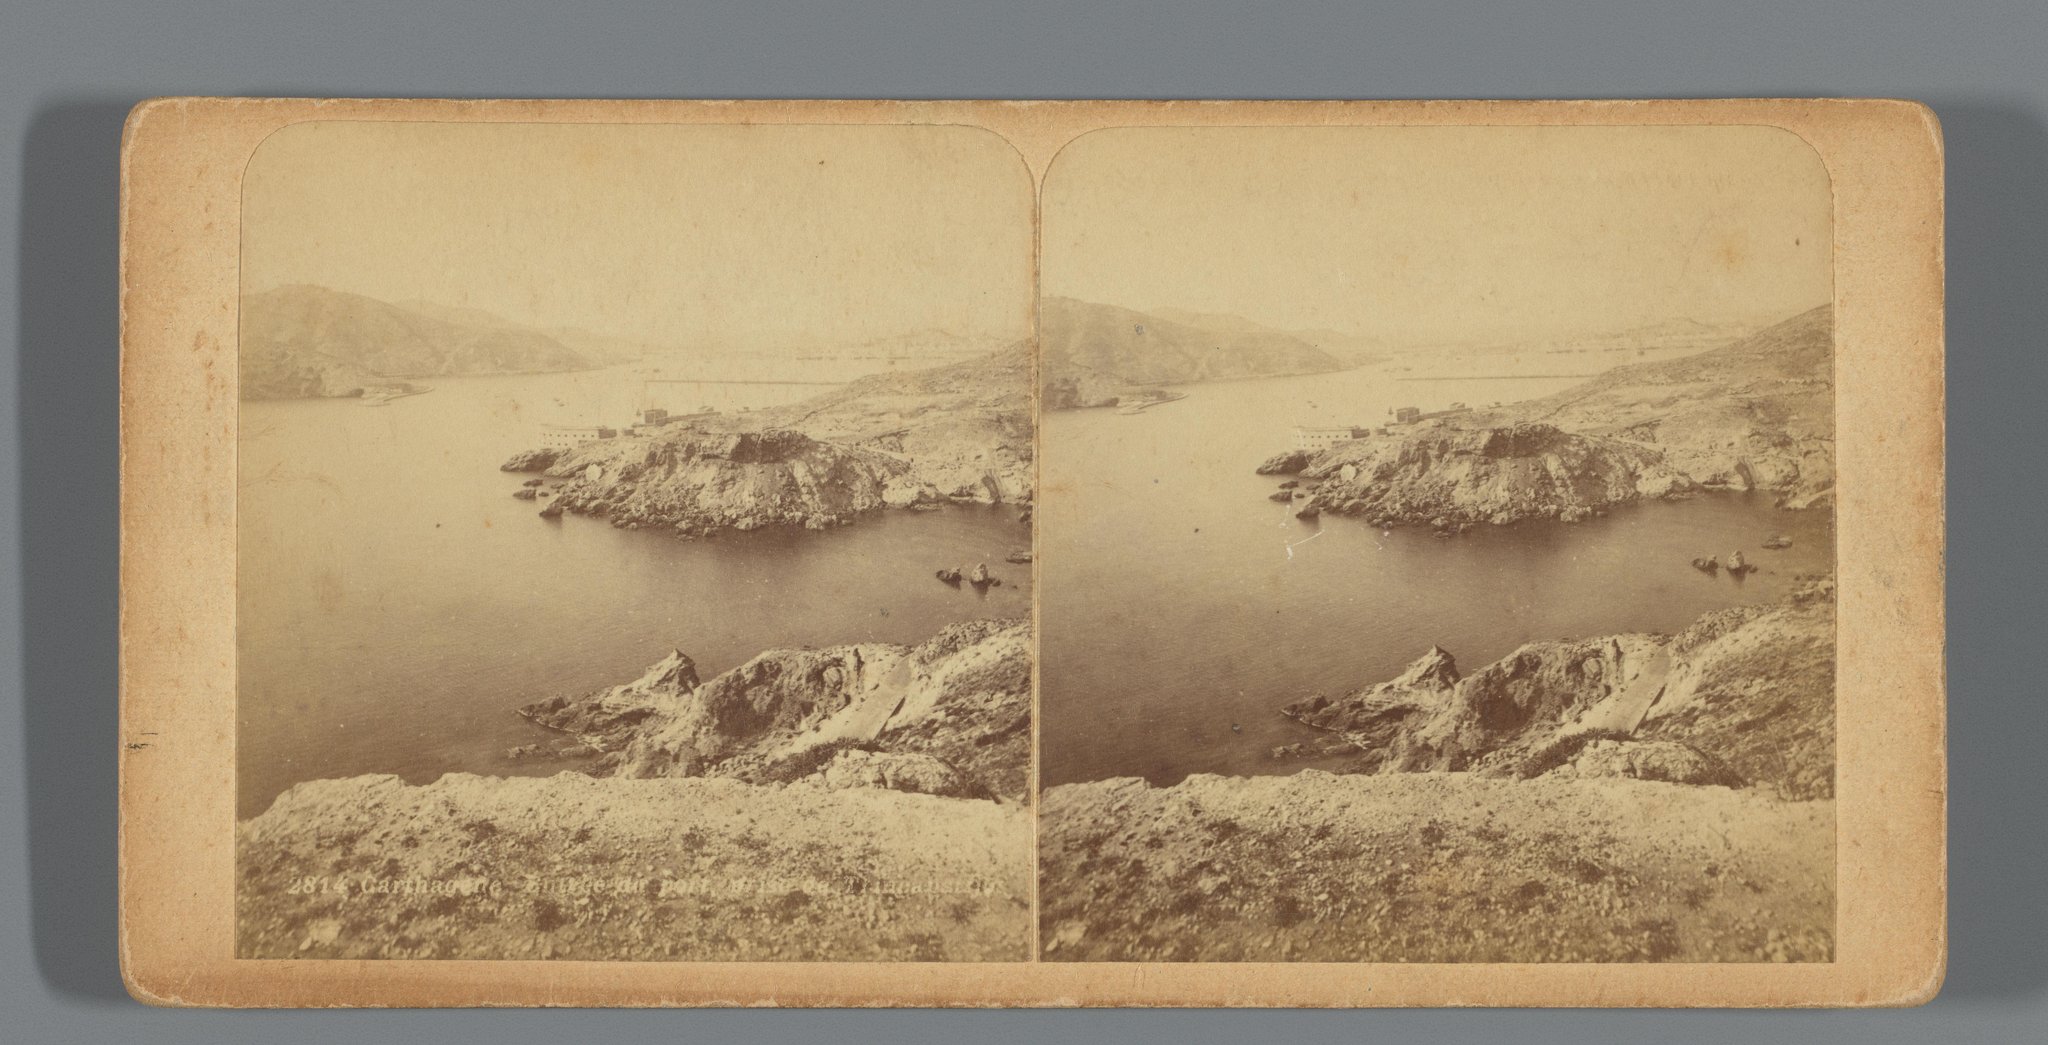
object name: stereograph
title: Aardrijkskundige Beeldengalerij, verzameld door M.J. Broekhuijsen, Hoofd eener school te Amsterdam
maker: martien johan broekhuijsen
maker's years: 1871-1956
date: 1905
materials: photographic support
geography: amsterdam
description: Onderdeel van een groep van 52 stereofoto's gebruikt in het lager onderwijs als aanvulling op schoolplaten. De gehele reeks bestond uit 274 nummers in 10 categorieën (A t/m K).